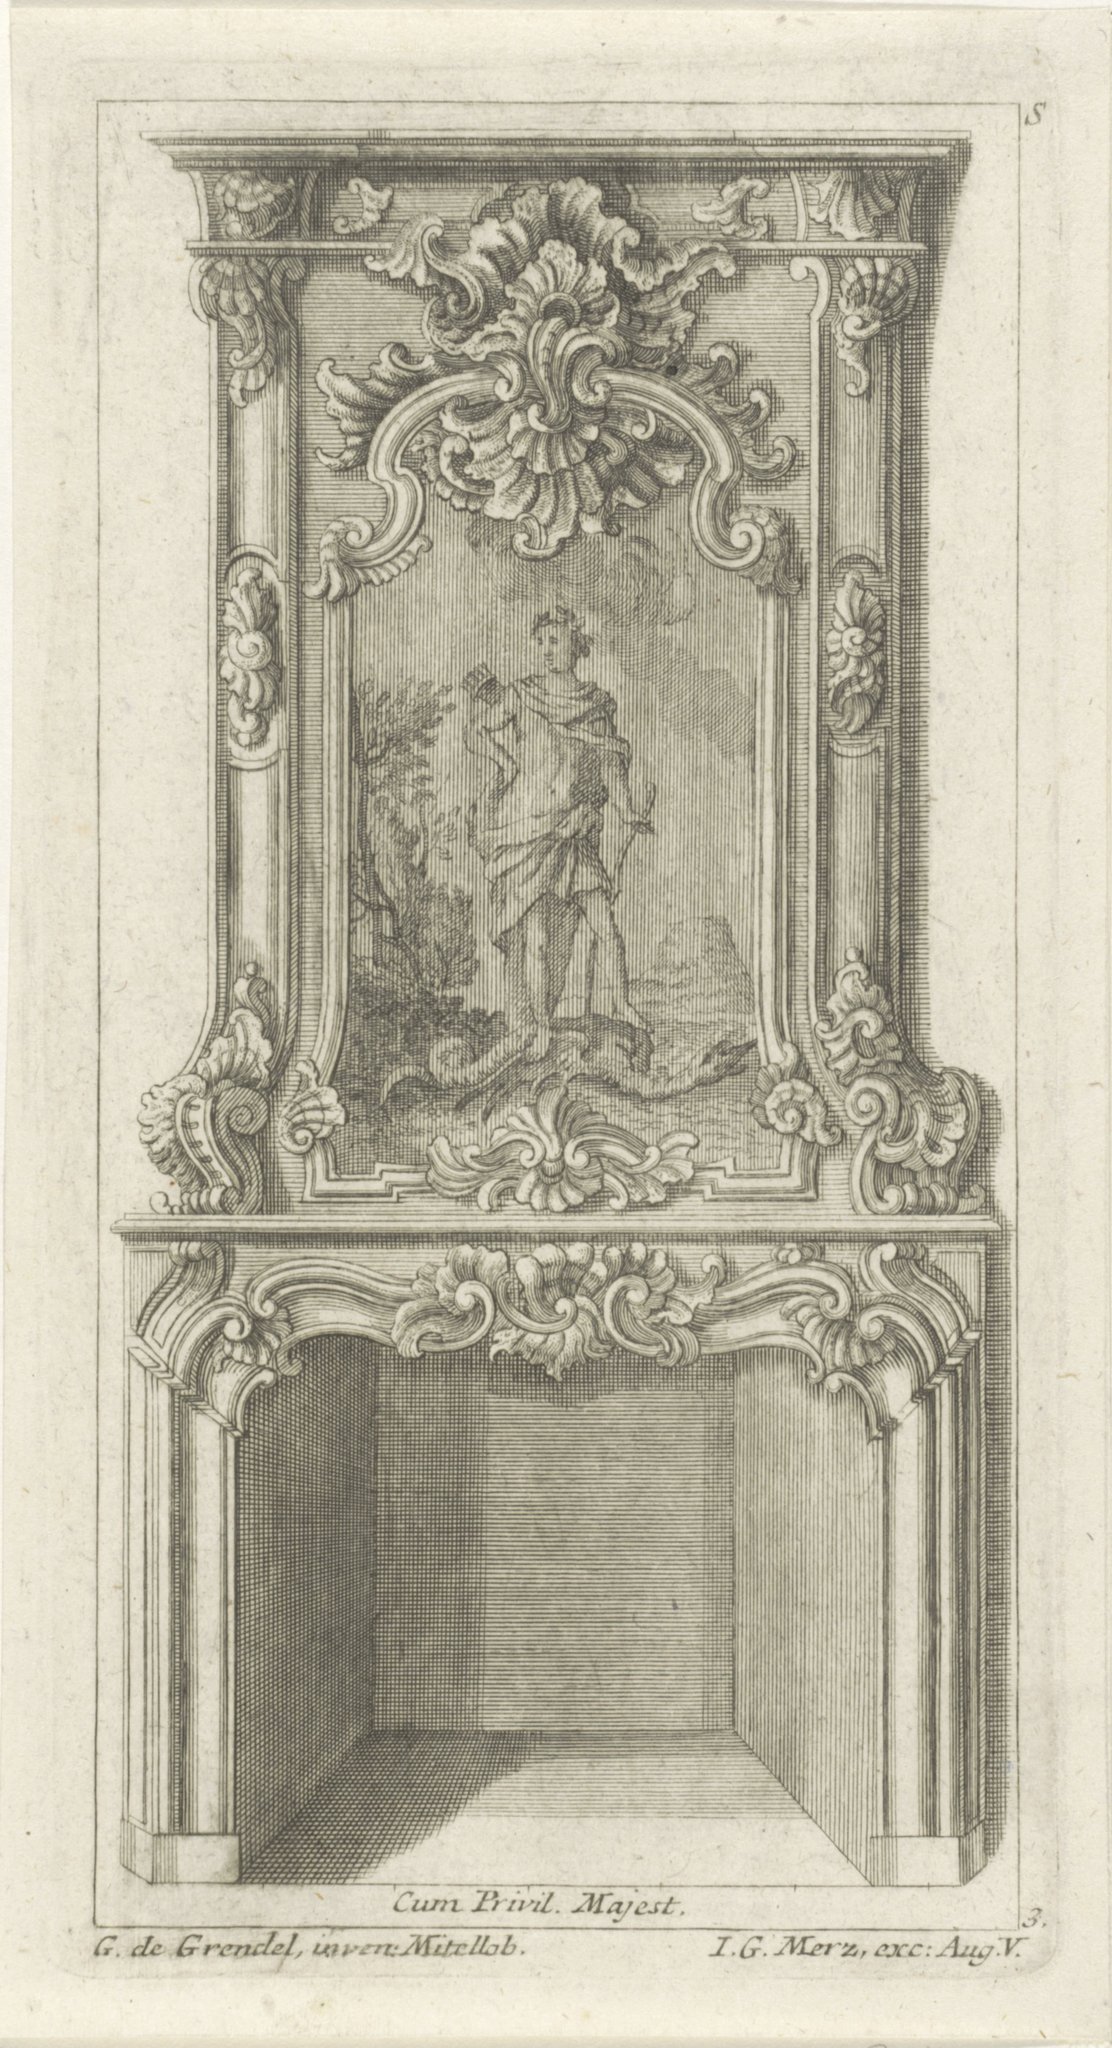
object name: ornament print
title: Neu inventirte Hollaendische Camine, Erster Theil, serie S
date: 1709-1762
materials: paper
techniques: engraving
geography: augsburg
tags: chimney, apollo shoots python, the dragon, rocaille ornament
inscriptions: collector's mark: Lugt 2228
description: Ontwerp voor een schoorsteen met een voorstelling van Apollo met pijlen en boog staande op de door hem overwonnen draak Python. De schoorsteenmantel is versierd met rocailleornamenten.